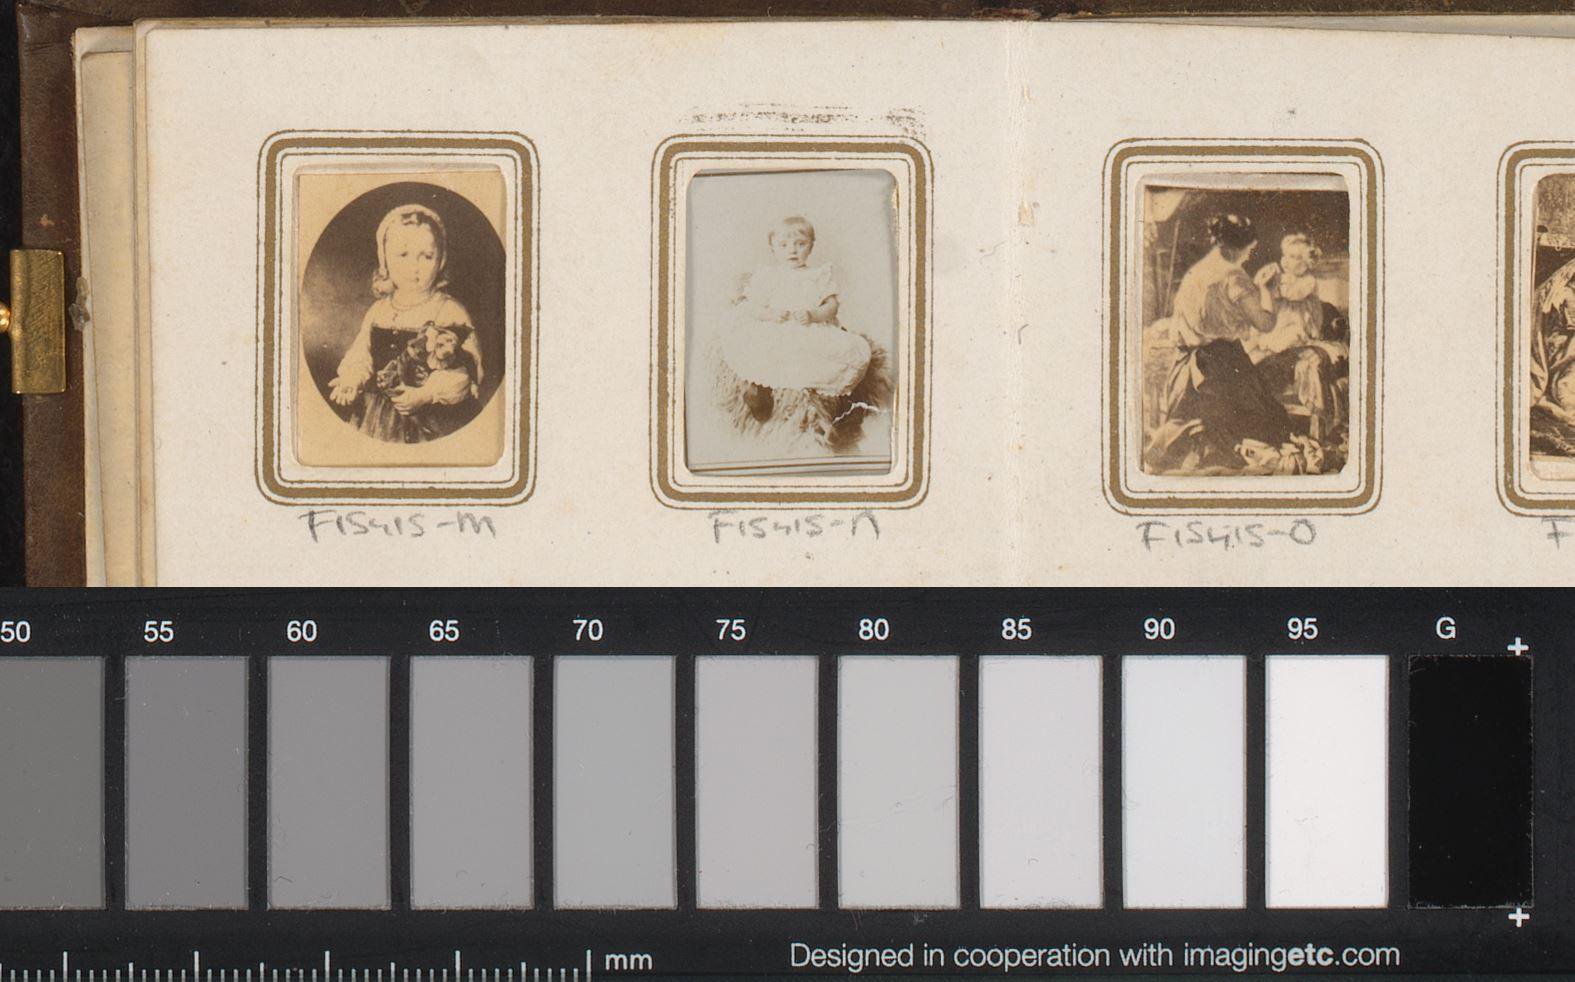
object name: photograph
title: Miniatuurportret van een onbekend kind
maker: Anonymous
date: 1880-1900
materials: paper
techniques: collodion silver print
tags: child, anonymous historical person portrayed